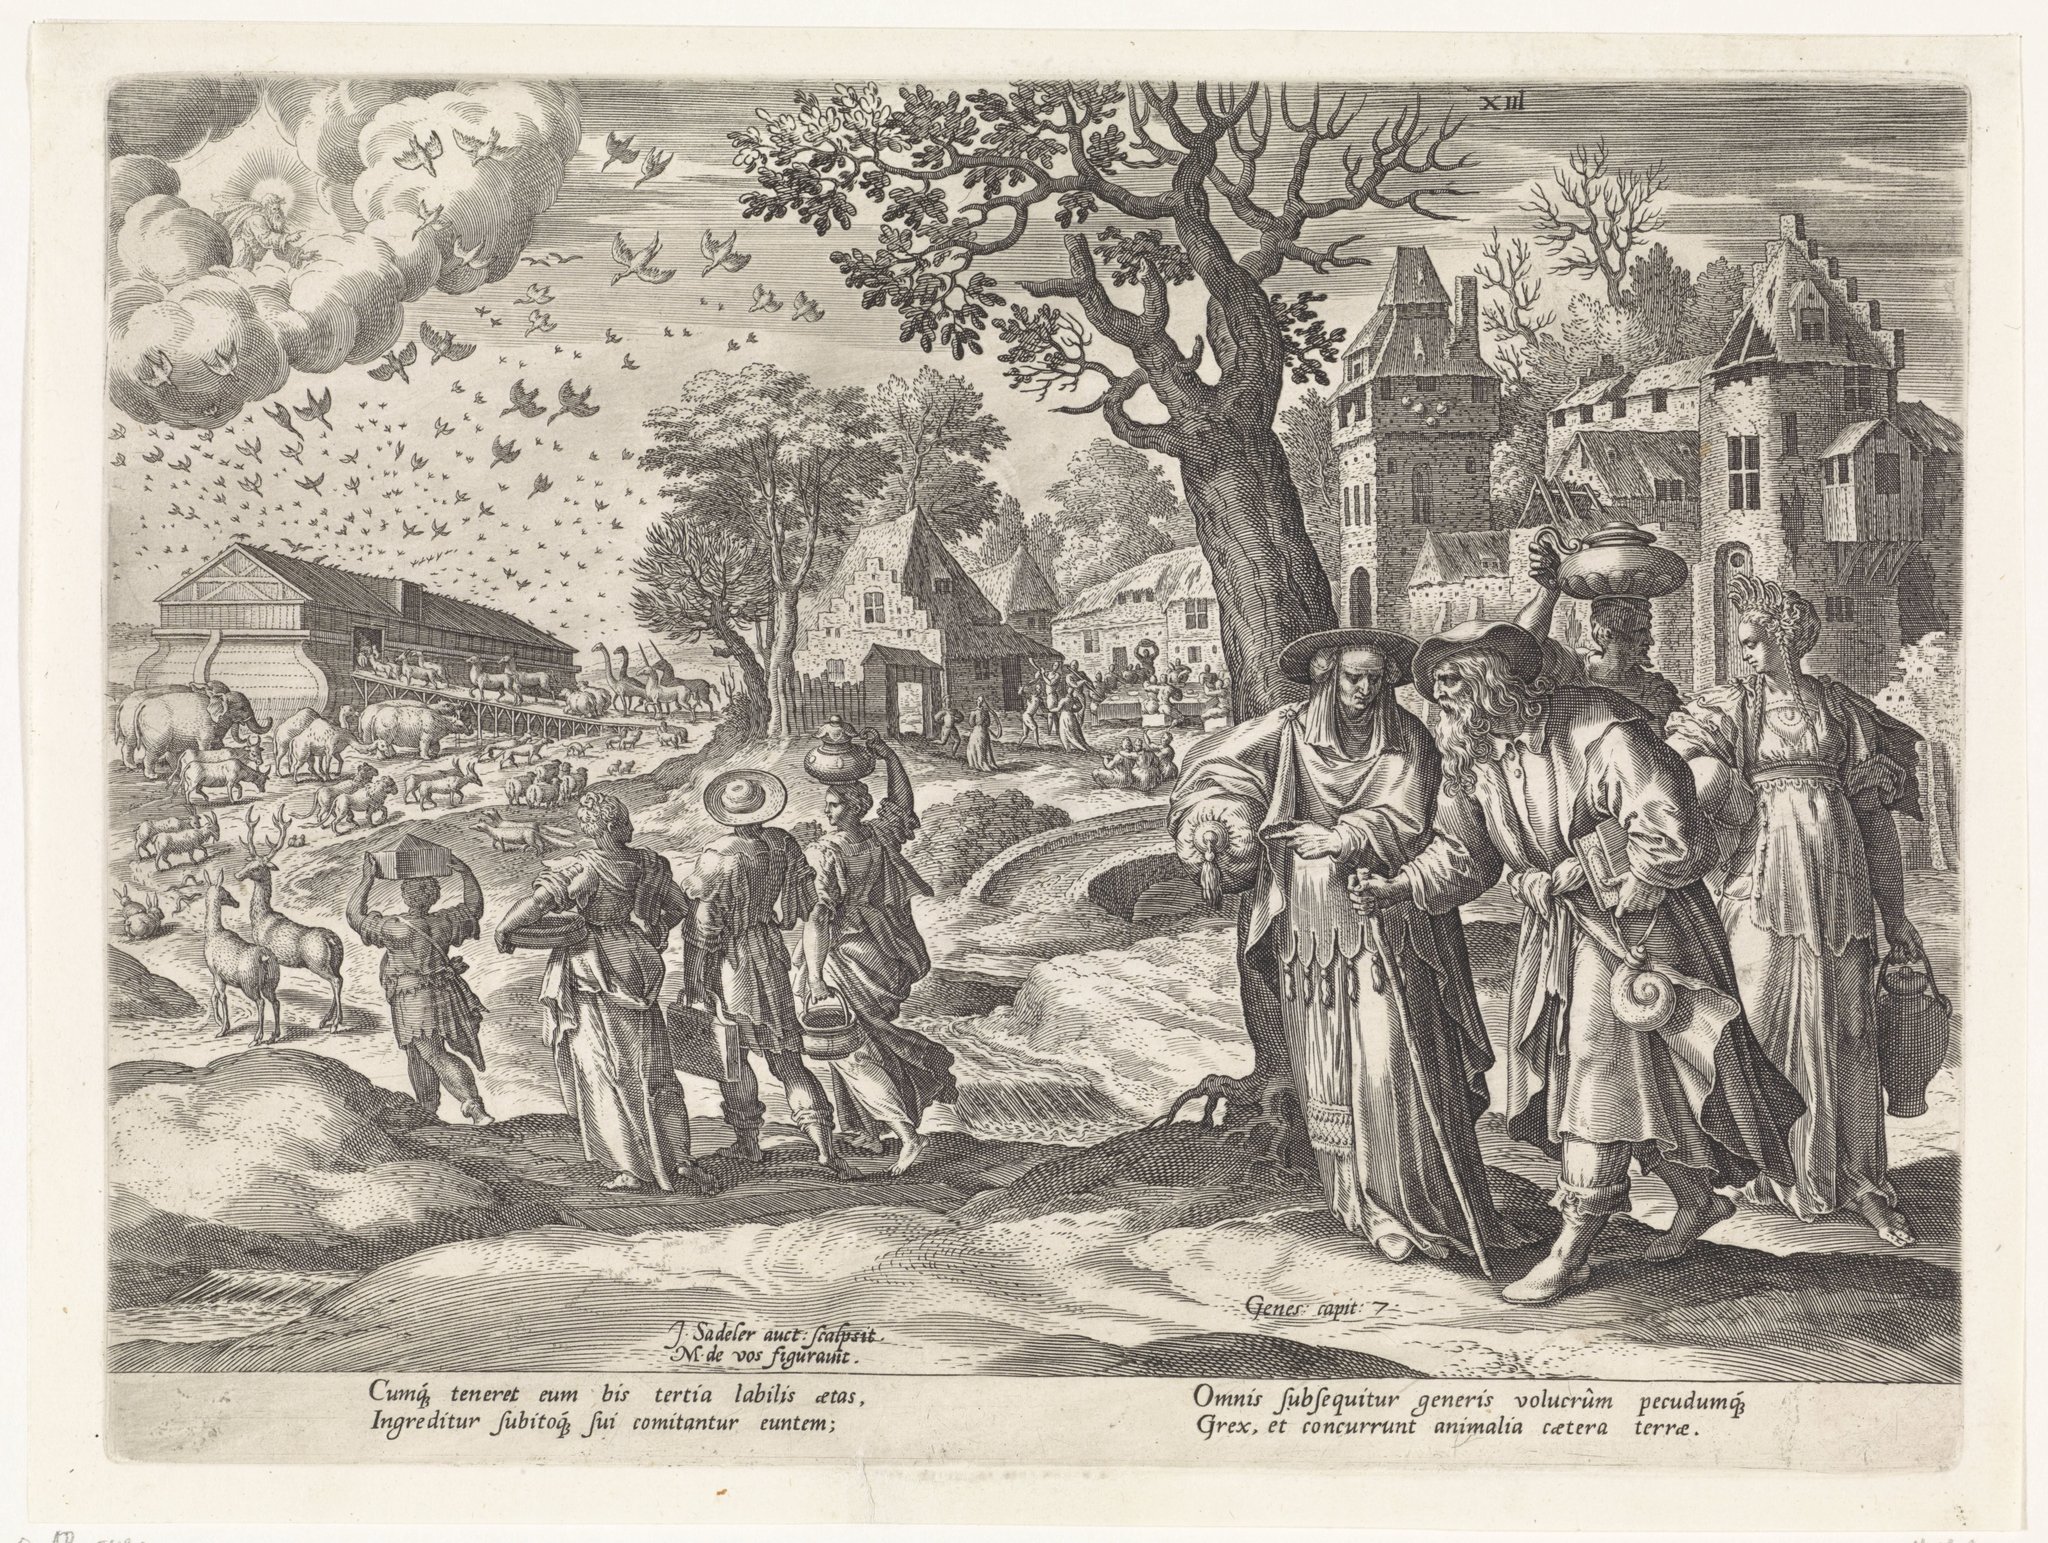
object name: print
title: Geschiedenis van de familie van Set / Over het goed en het slecht oordelen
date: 1586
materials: paper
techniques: engraving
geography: antwerp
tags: the animals enter the ark, the gathering of the animals in pairs ~ story of noah, god the father as bearded old man, usually with crown or tiara or sceptre and/or globe, noah and his family enter the ark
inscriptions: collector's mark: Lugt 240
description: God roept van alle dieren van de wereld één paar naar de ark om door Noach gered te worden. Op de voorgrond Noach en zijn familie die richting de ark wandelen met al hun bezittingen. Op de achtergrond rechts wordt er gefeest en gedanst in een dorp. De prent heeft een Latijns onderschrift.